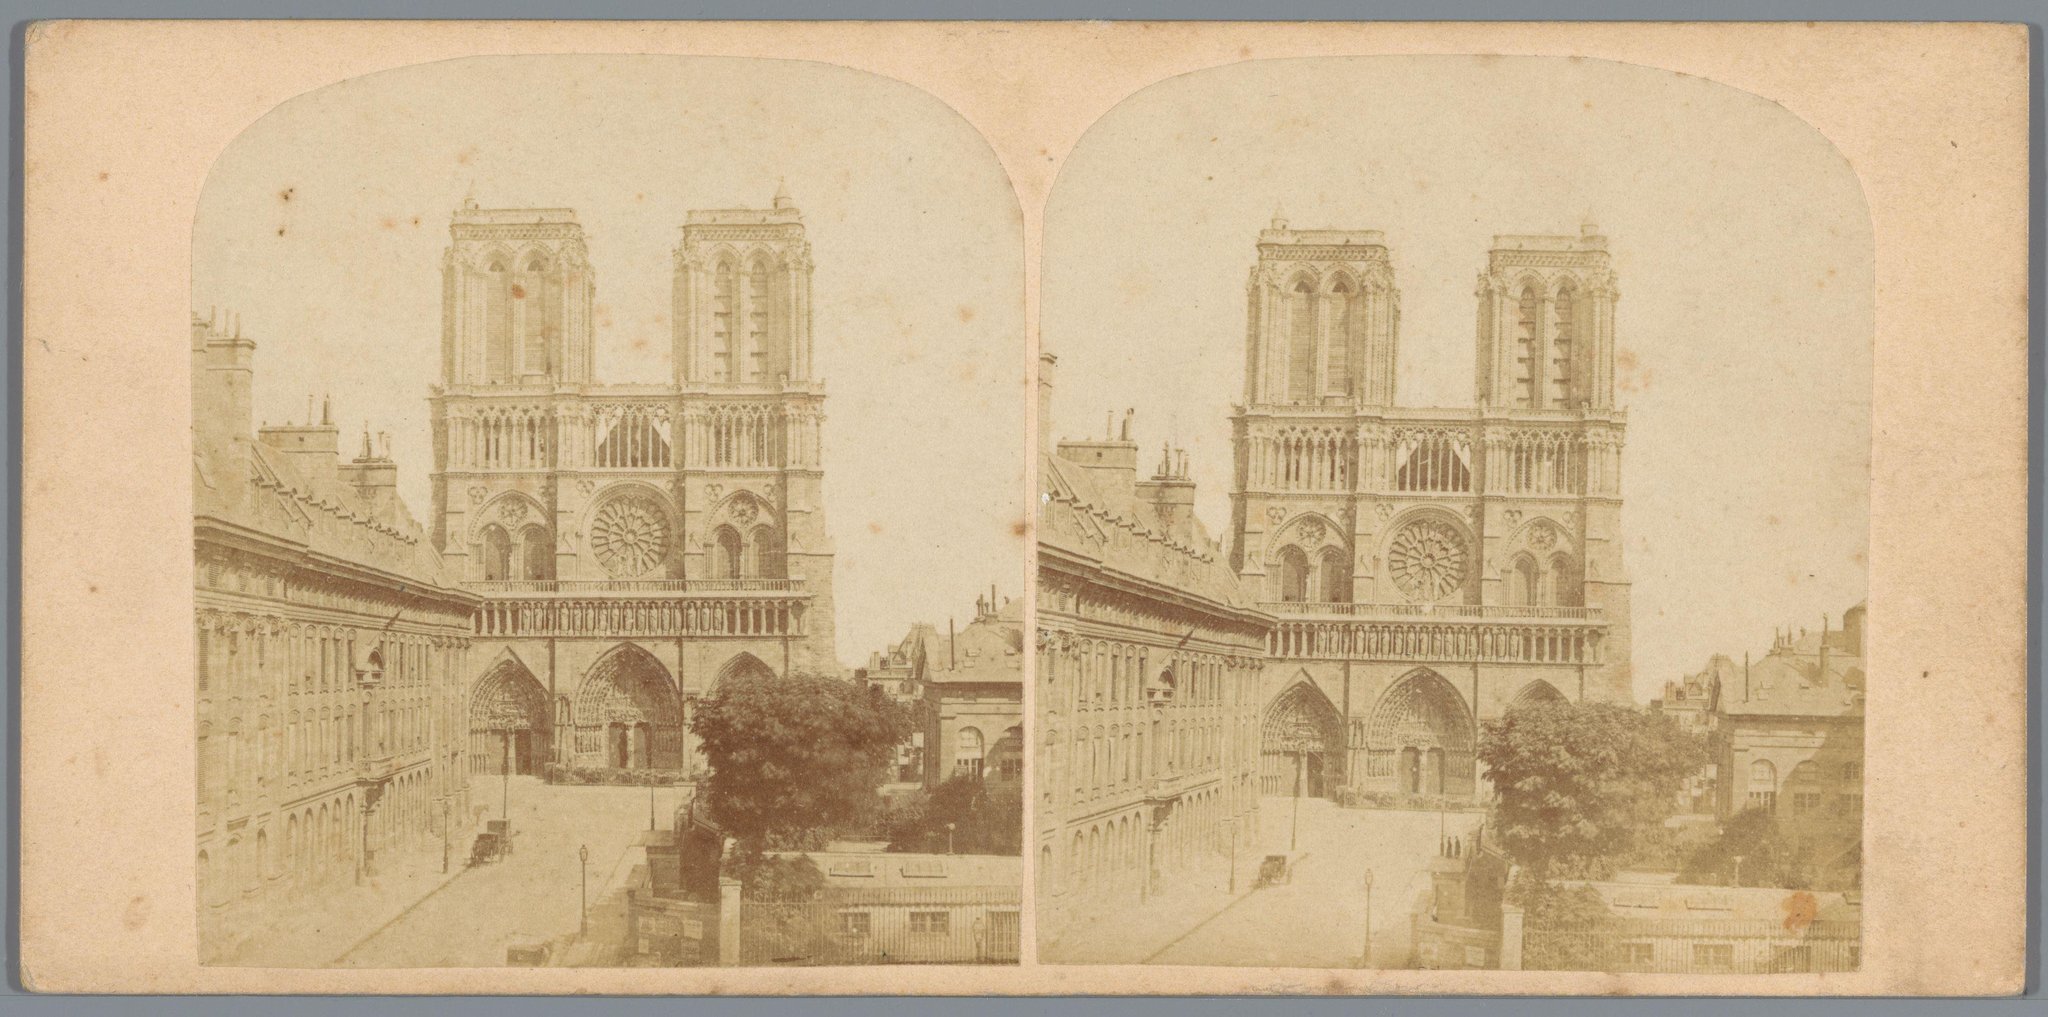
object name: stereograph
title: Gezicht op de façade van de Notre-Dame in Parijs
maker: Anonymous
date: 1850-1880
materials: cardboard, photographic support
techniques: albumen print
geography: paris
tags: parts of church exterior and annexes: façade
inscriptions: inscription: ‘Notre Dame de Paris’